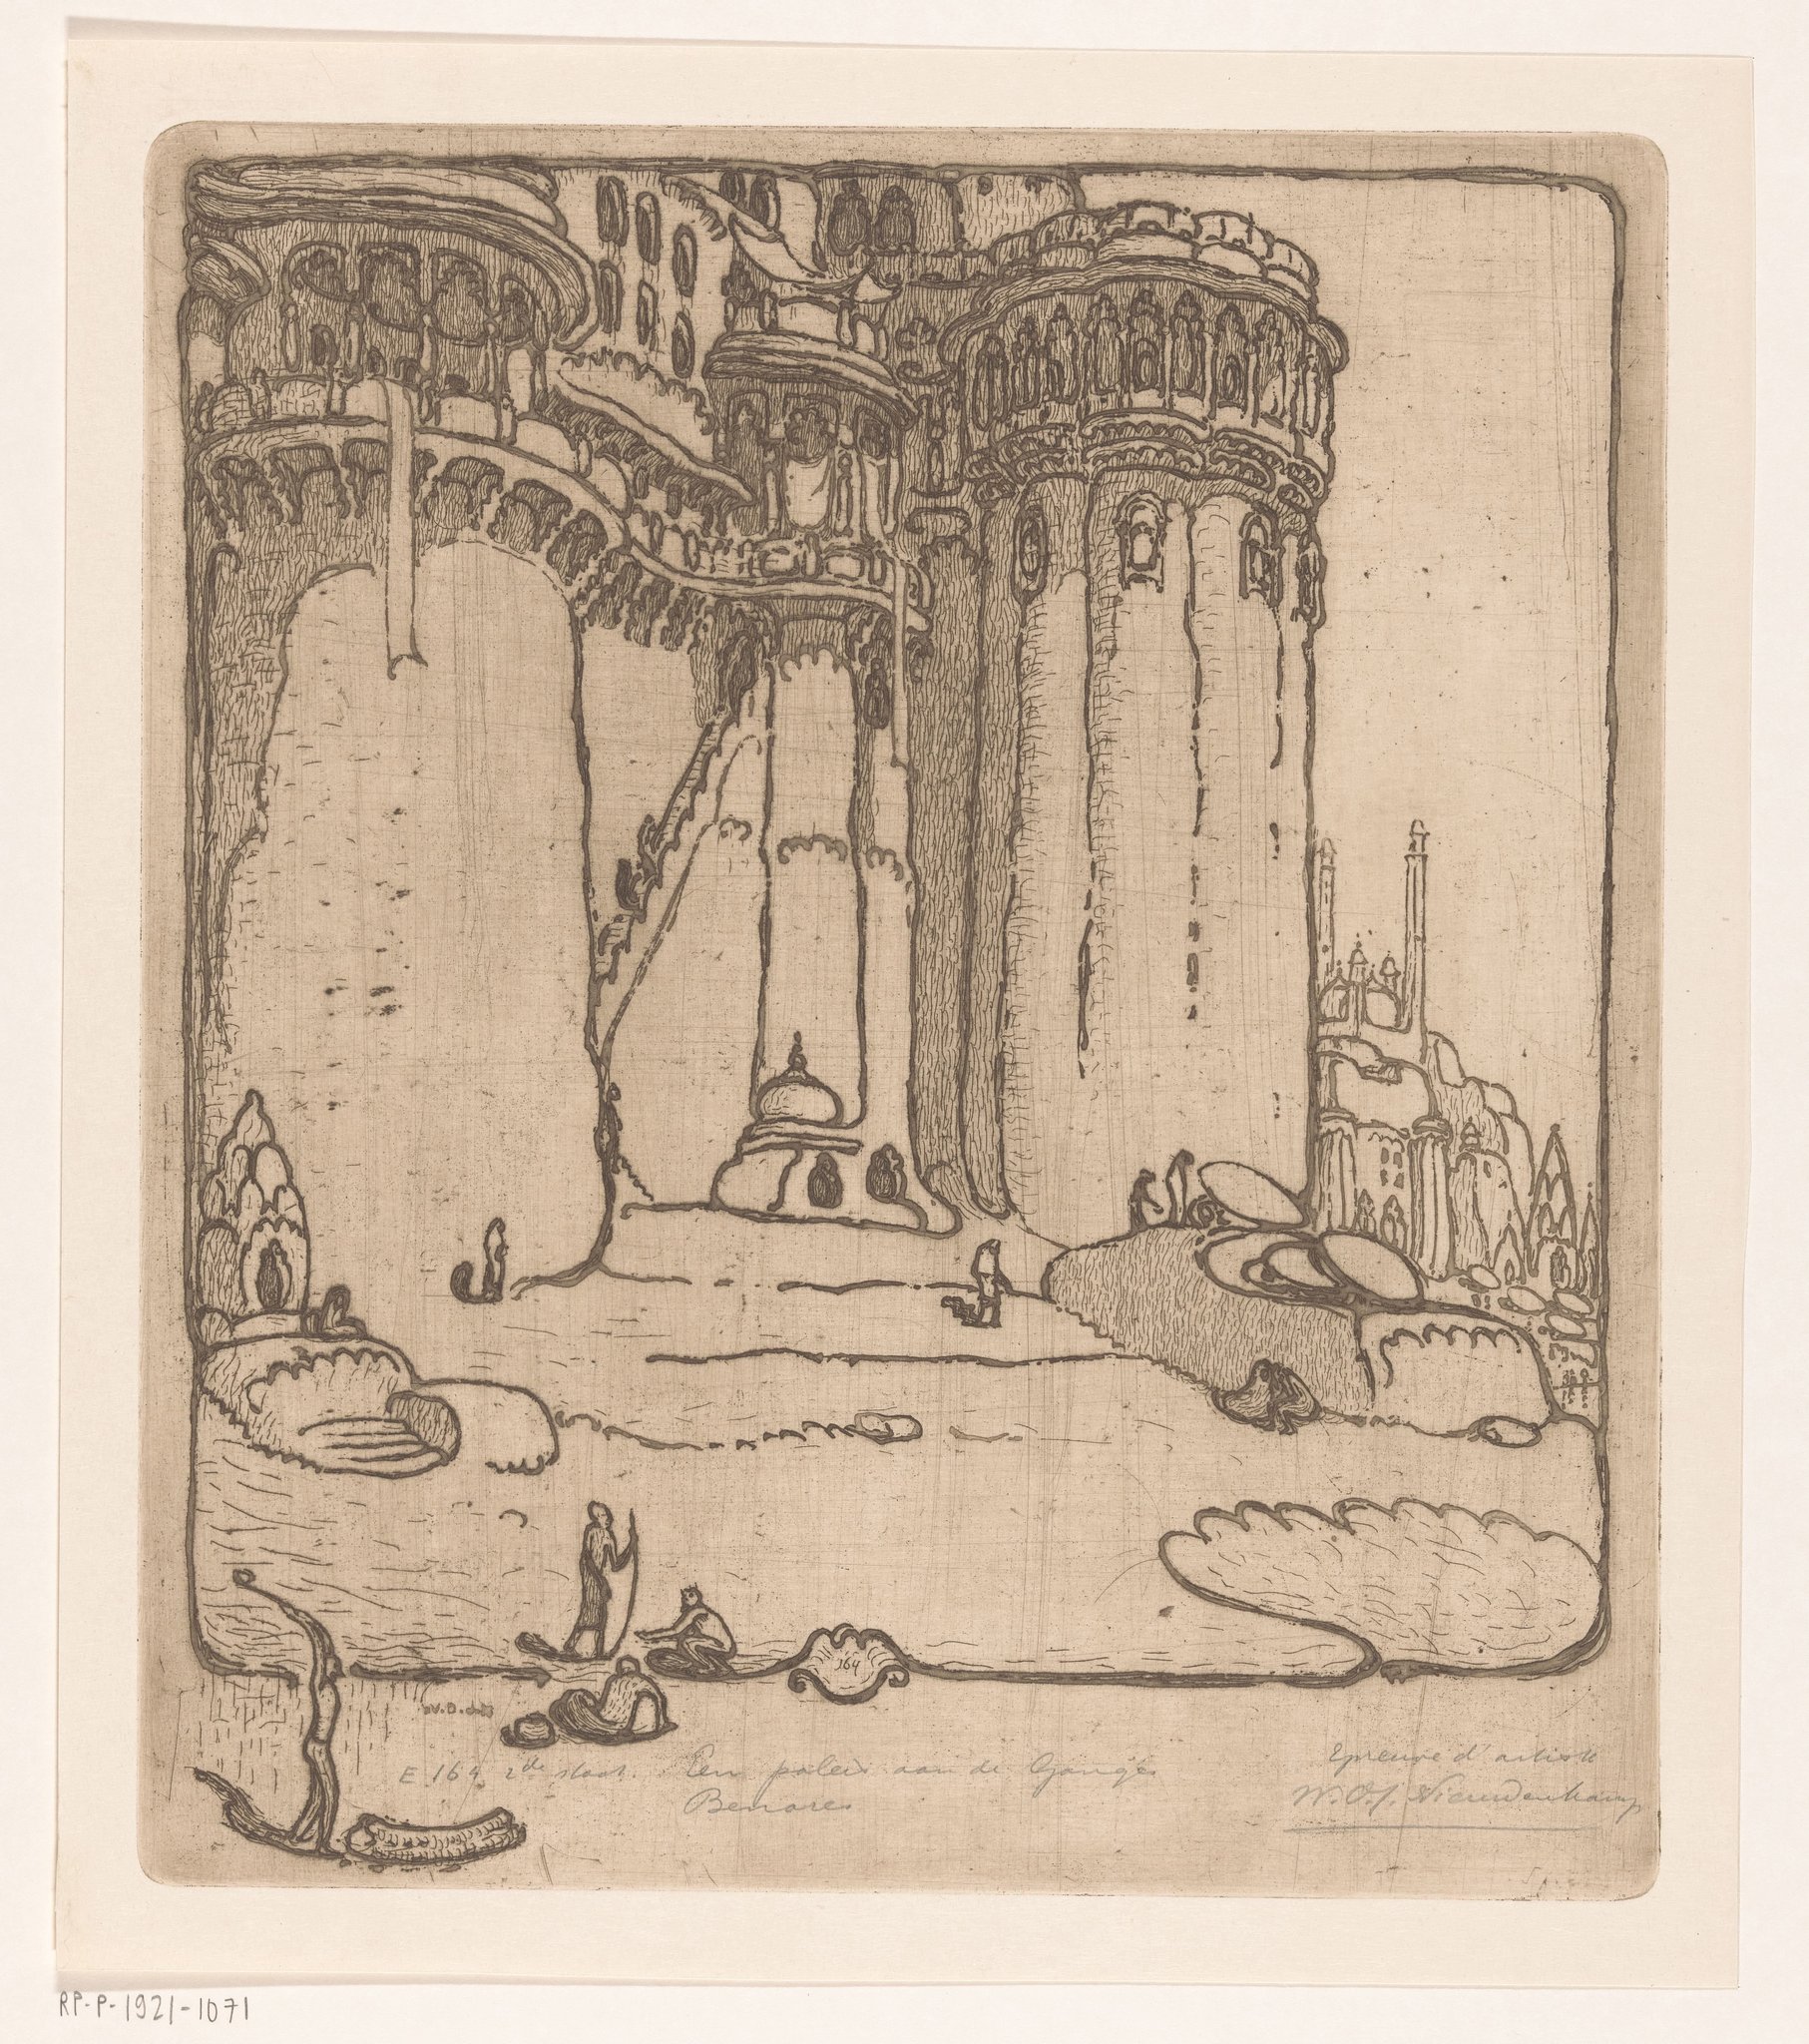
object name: print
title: Een paleis aan de Ganges, Benares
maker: wijnand otto jan nieuwenkamp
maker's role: draughtsman, print maker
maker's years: 1874-1950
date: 1905-1915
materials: paper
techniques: intaglio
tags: woodcutting, woodcutter ~ forestry, palace, temple, shrine ~ islam, mohammedanism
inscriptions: collector's mark: Lugt 2233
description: Een paleis met twee torens aan de oever van de Ganges in Benares. Op de voorgrond een man die hout hakt. Rechts op de achtergrond een moskee, mogelijk de Aurangzeb-moskee, ook bekend als de Alamgir-moskee.